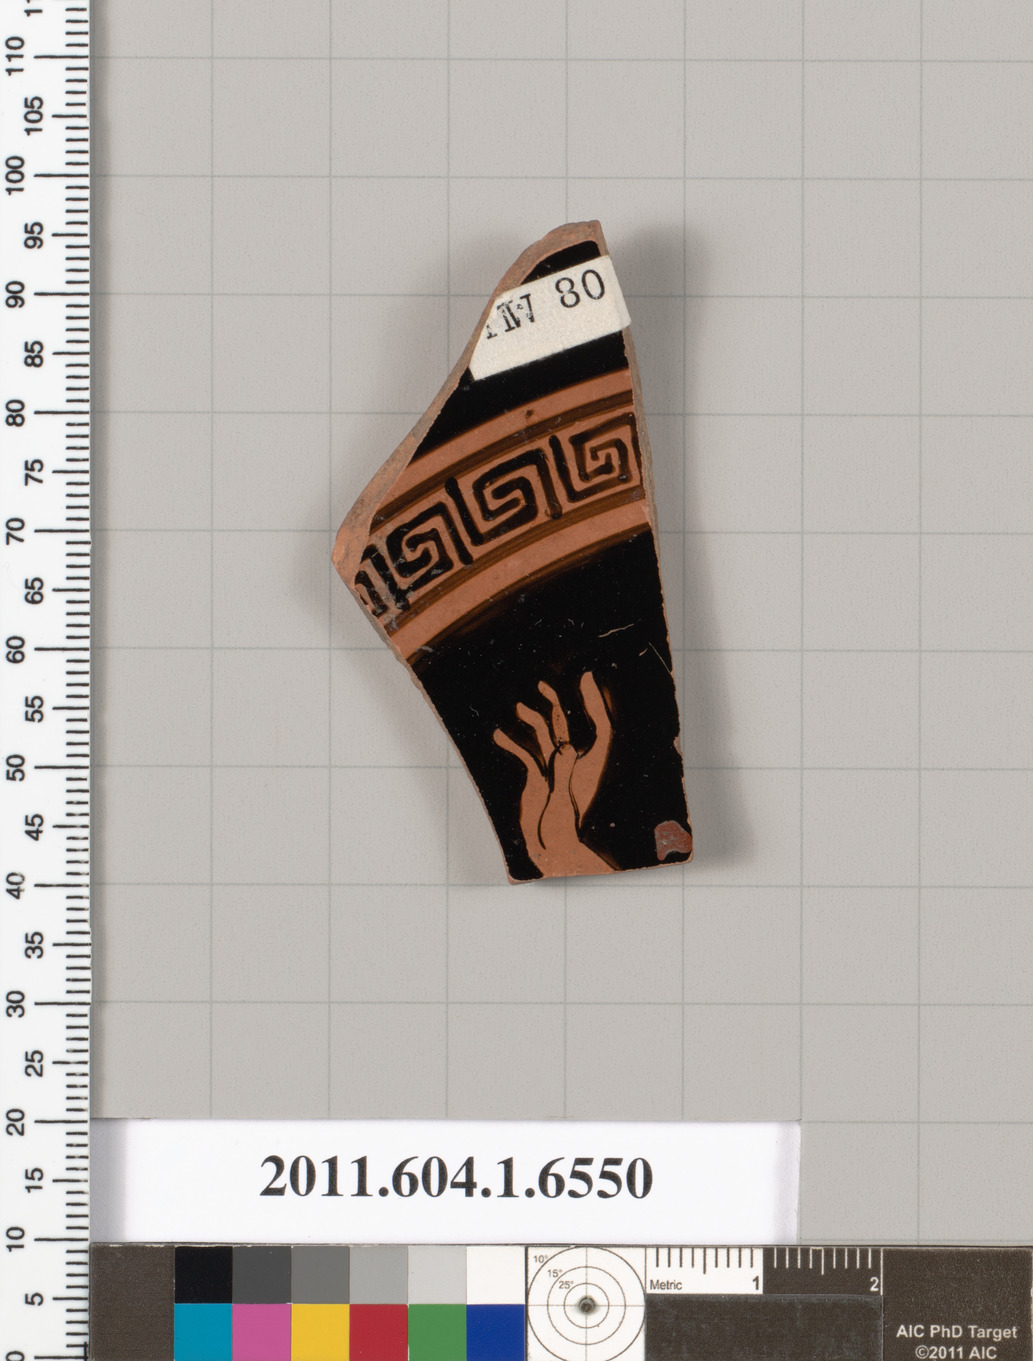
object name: kylix fragment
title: Terracotta fragment of a kylix (drinking cup)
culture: greek, attic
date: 490-480 BCE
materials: terracotta